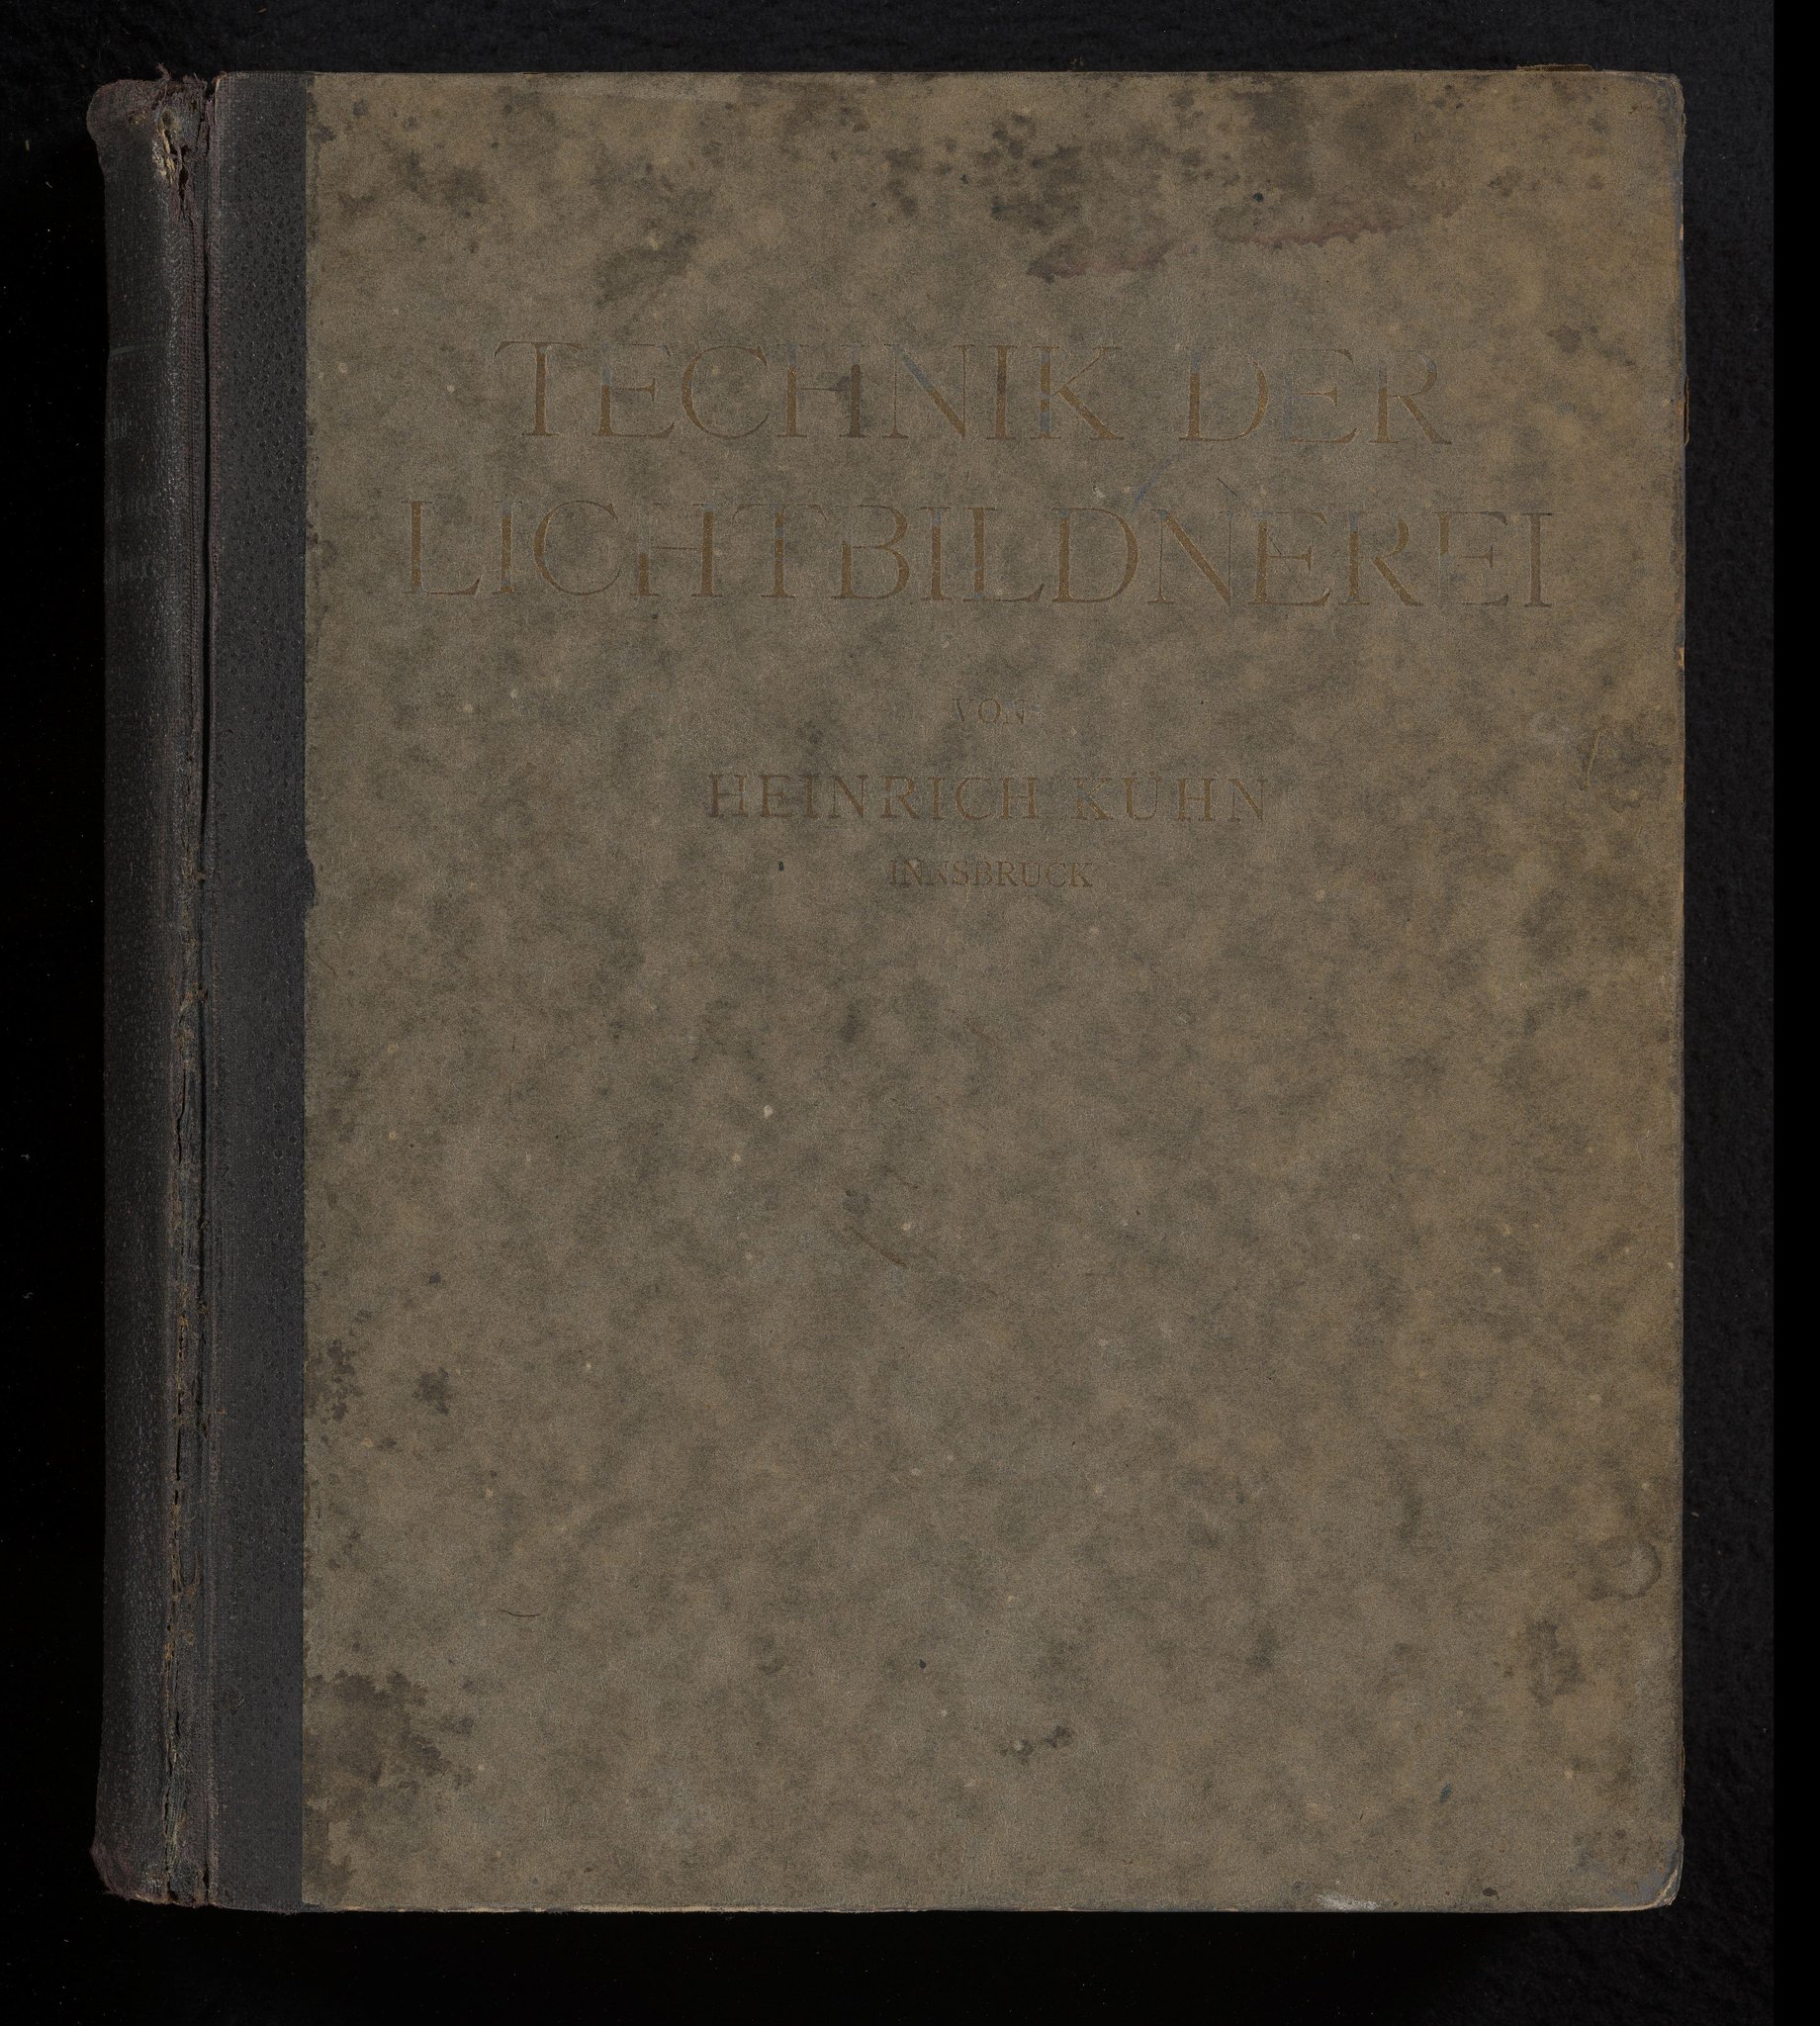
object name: book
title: Technik der Lichtbildnerei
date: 1921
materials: cardboard, paper, textile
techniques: letterpress printing, rotogravure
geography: halle an der saale